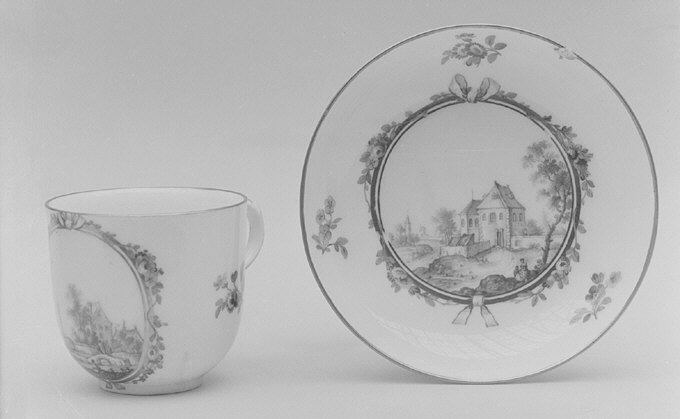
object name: cup and saucer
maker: royal porcelain manufactory, berlin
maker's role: manufactory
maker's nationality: german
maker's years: 1763-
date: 1775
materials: hard paste porcelain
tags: buildings